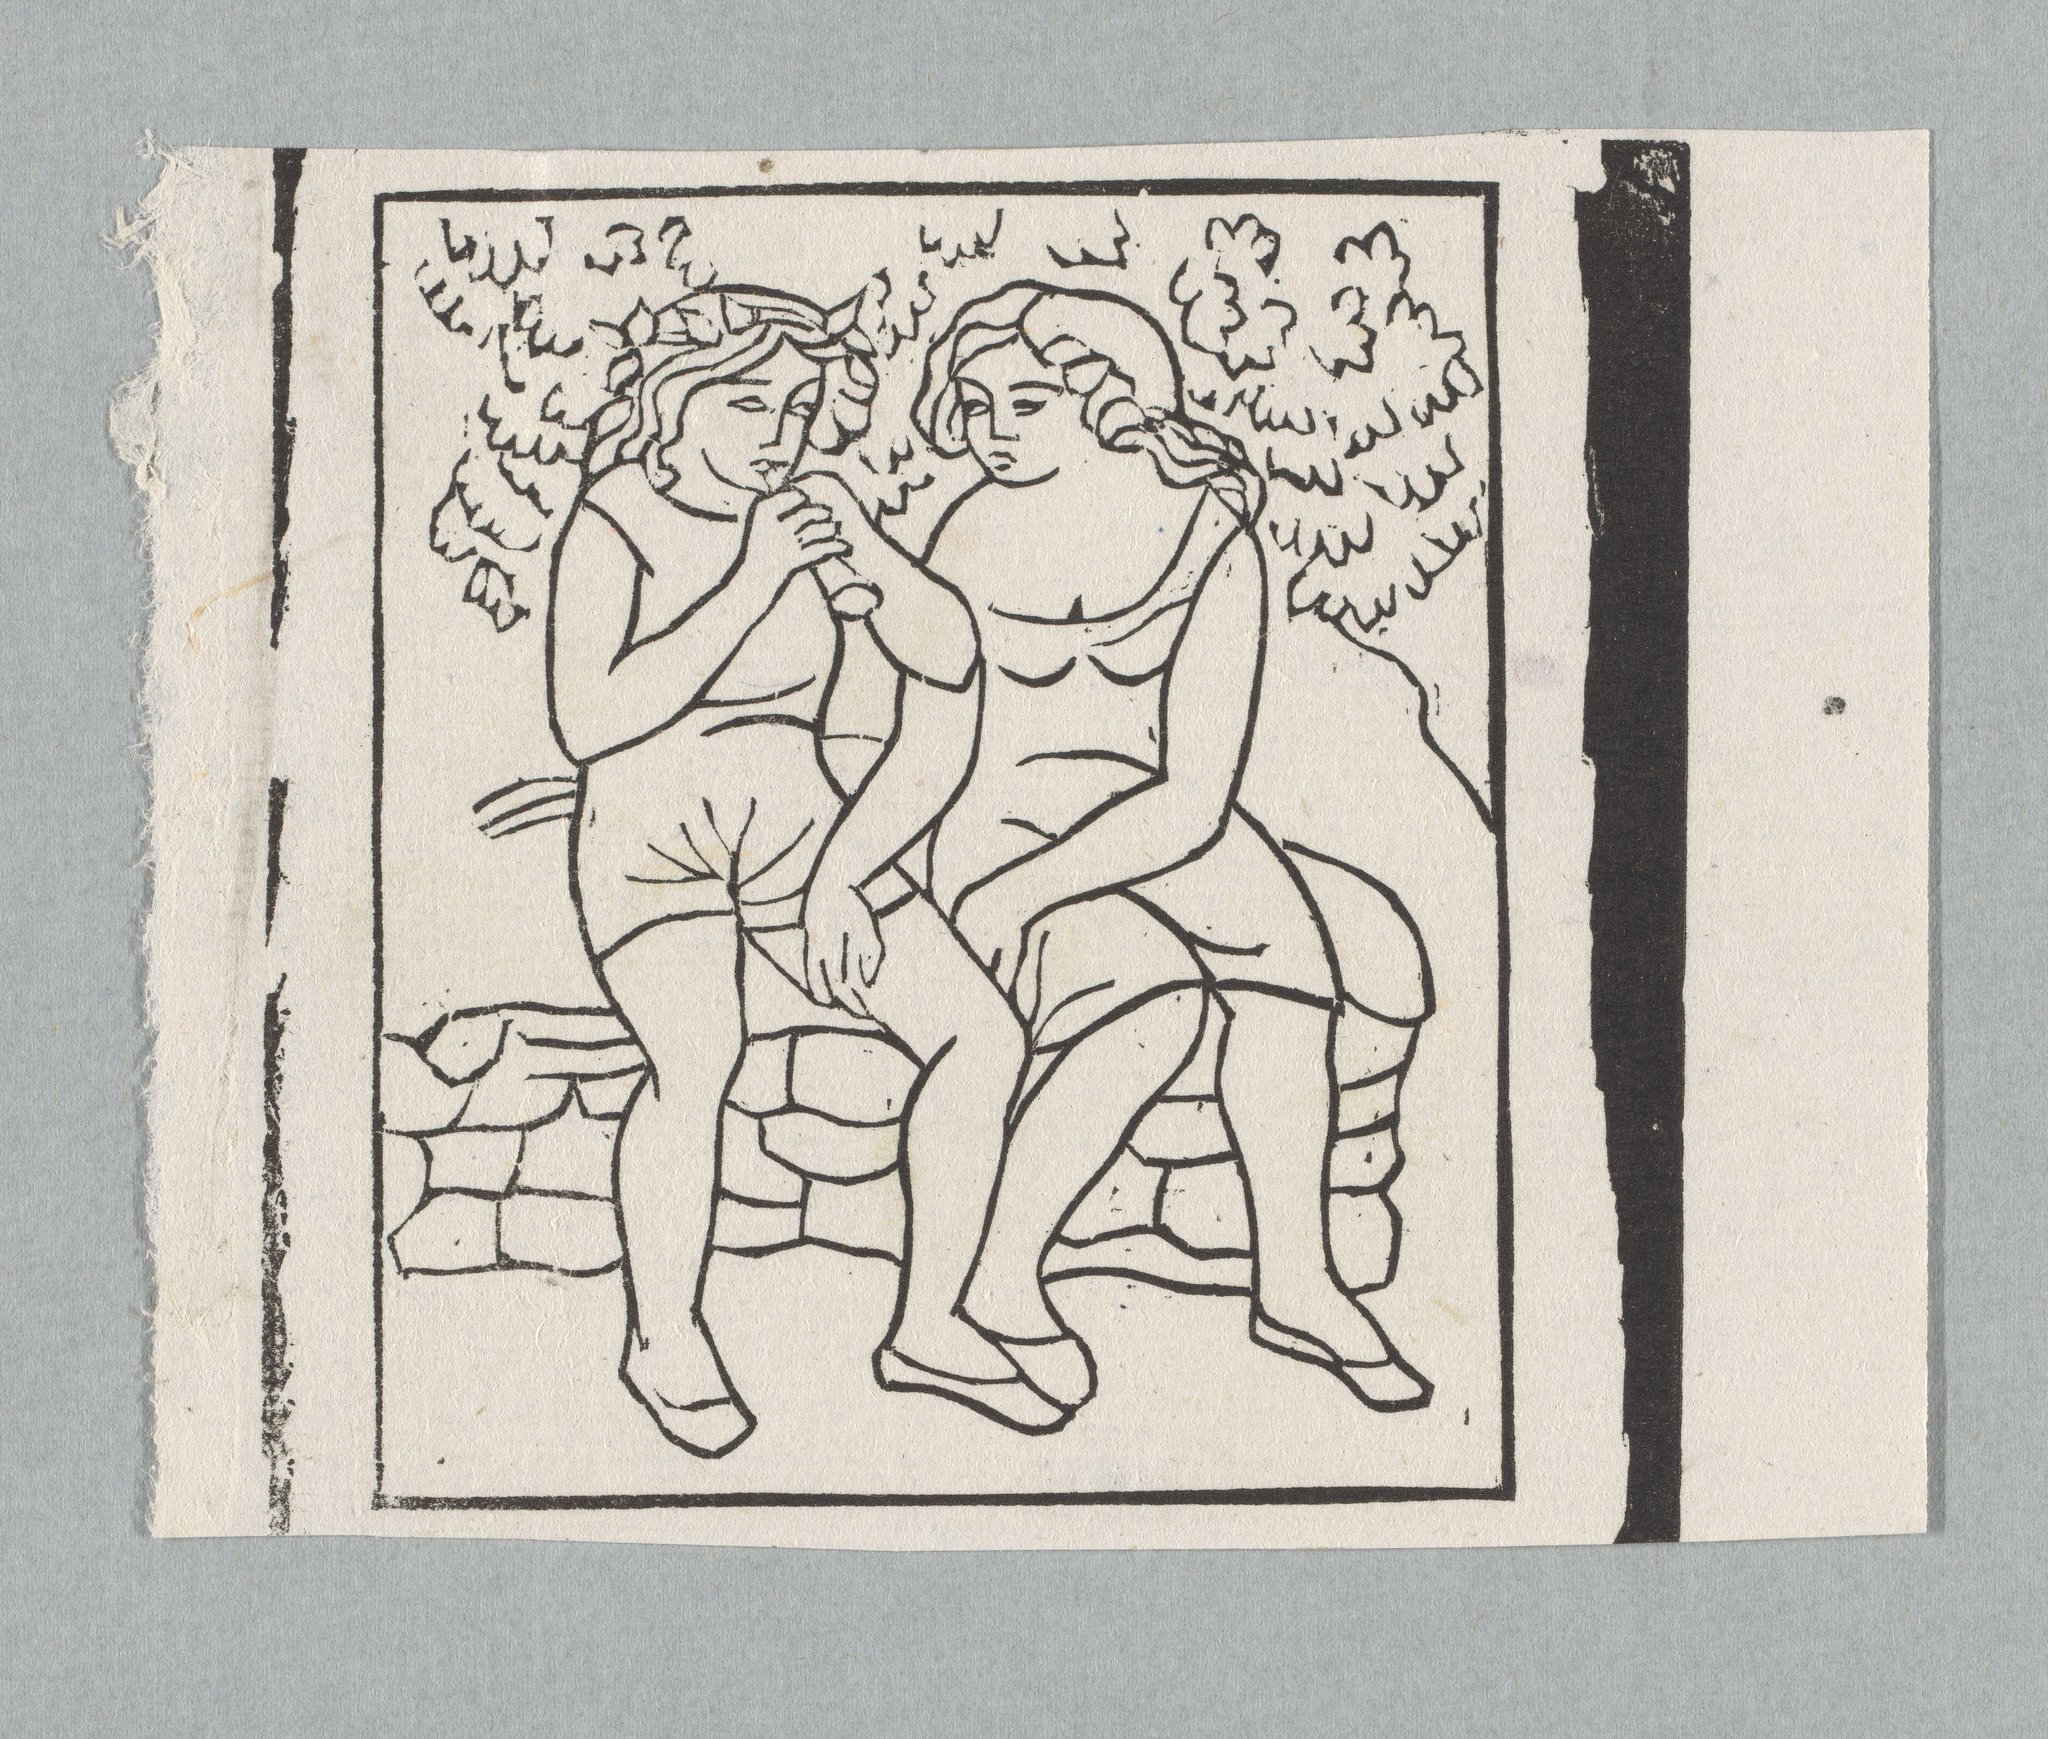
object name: book illustration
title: Daphnis leert Chloë fluit spelen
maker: aristide maillol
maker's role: draughtsman, painter, print maker, sculptor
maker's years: 1861-1944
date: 1937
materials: paper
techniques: woodcut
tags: panpipes, musician training pupils, music-lesson - cc - out of doors (+ variant), daphnis (in greek mythology a shepherd who invented pastoral poetry, chloe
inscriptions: collector's mark: Lugt 2228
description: Latere staat van deze prent gebruikt in: Longus. Les Pastorales de Longus ou Daphnis & Chloé. Parijs: Frères Gonin, 1935, p. 47.